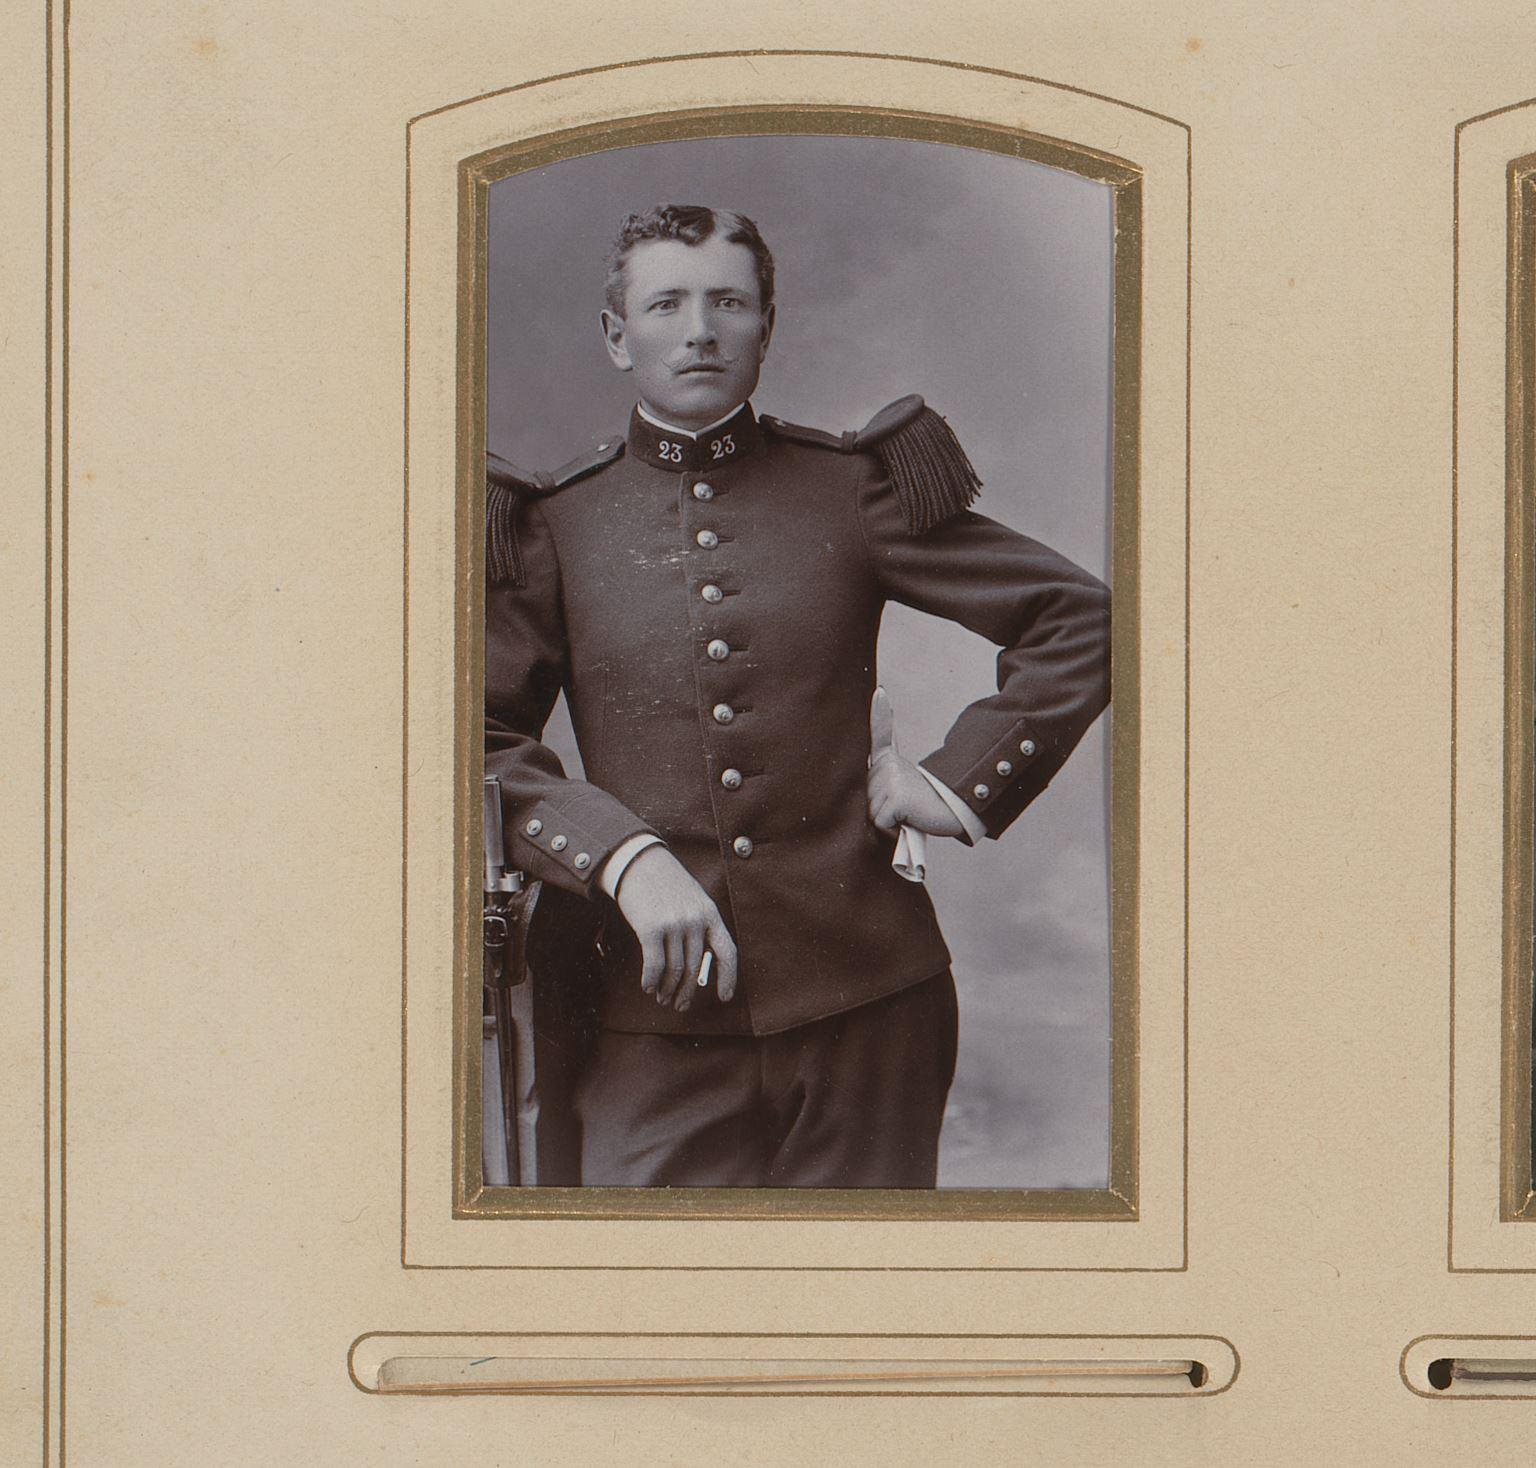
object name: photograph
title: Portret van een jonge man in uniform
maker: désiré duval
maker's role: fotograaf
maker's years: 1865-1930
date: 1880-1920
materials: cardboard, photographic support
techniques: collodion silver print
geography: bourg-en-bresse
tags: historical persons, youth, adolescent, (military) uniforms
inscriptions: inscription: ‘Ancne Mai or/ Gaudichon/ D. Duval/ Successeur/ 1./ Place Joubert/ Bourg (Ain)/ Atelier de Pose a la Lumière Artificielle/ Tous les Clichés étant conservés on peut avoir/ de nouvelles Cartes sans poser de nouveau.’